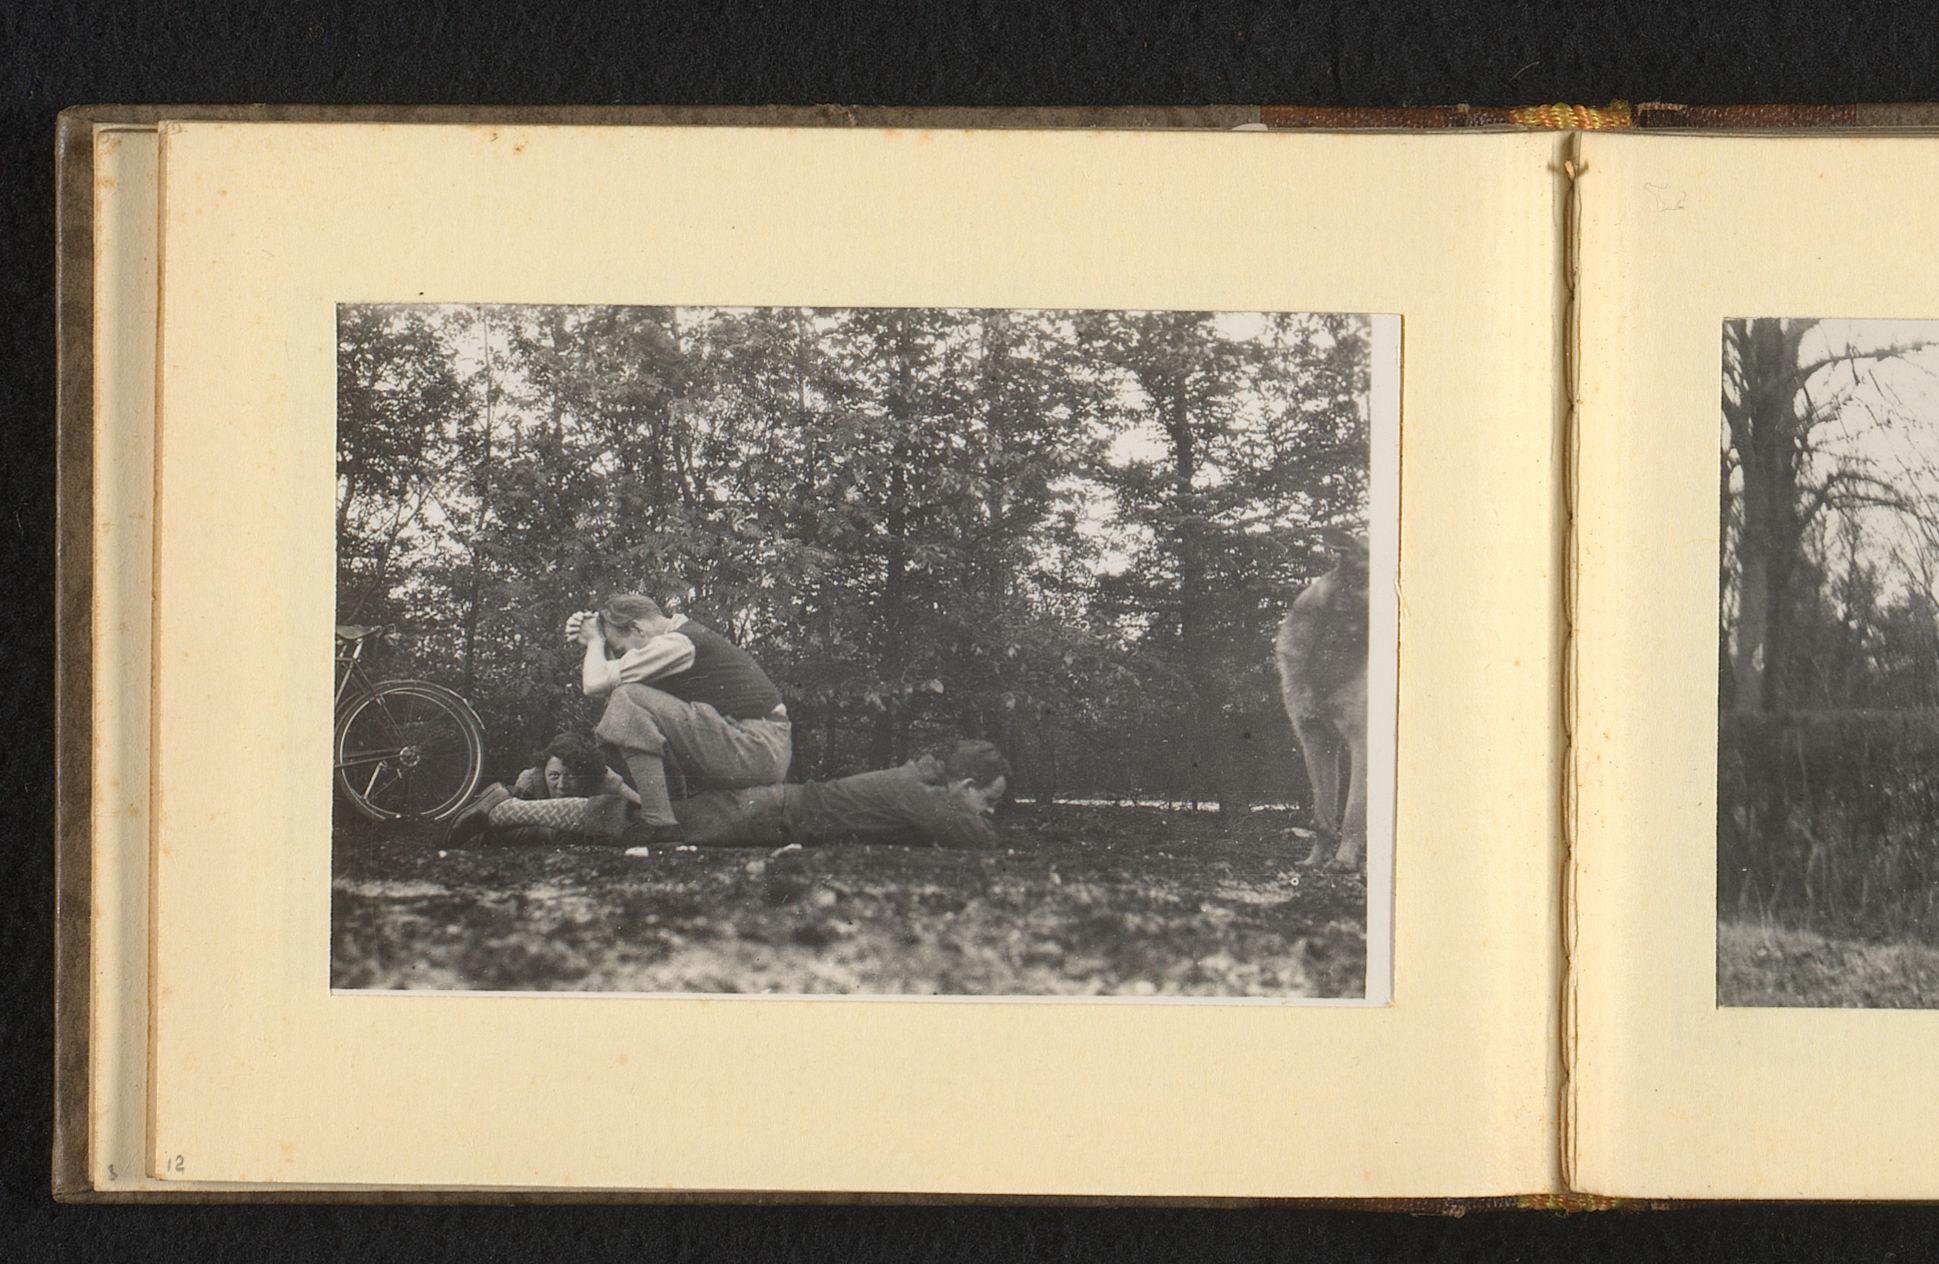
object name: photograph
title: Drie mensen op de grond in het bos, rechts een hond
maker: norbert van den berg (1901-1972)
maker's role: amateurfotograaf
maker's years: 1901-1972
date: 1935-1950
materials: paper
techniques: gelatin silver print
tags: sitting on the ground, dog